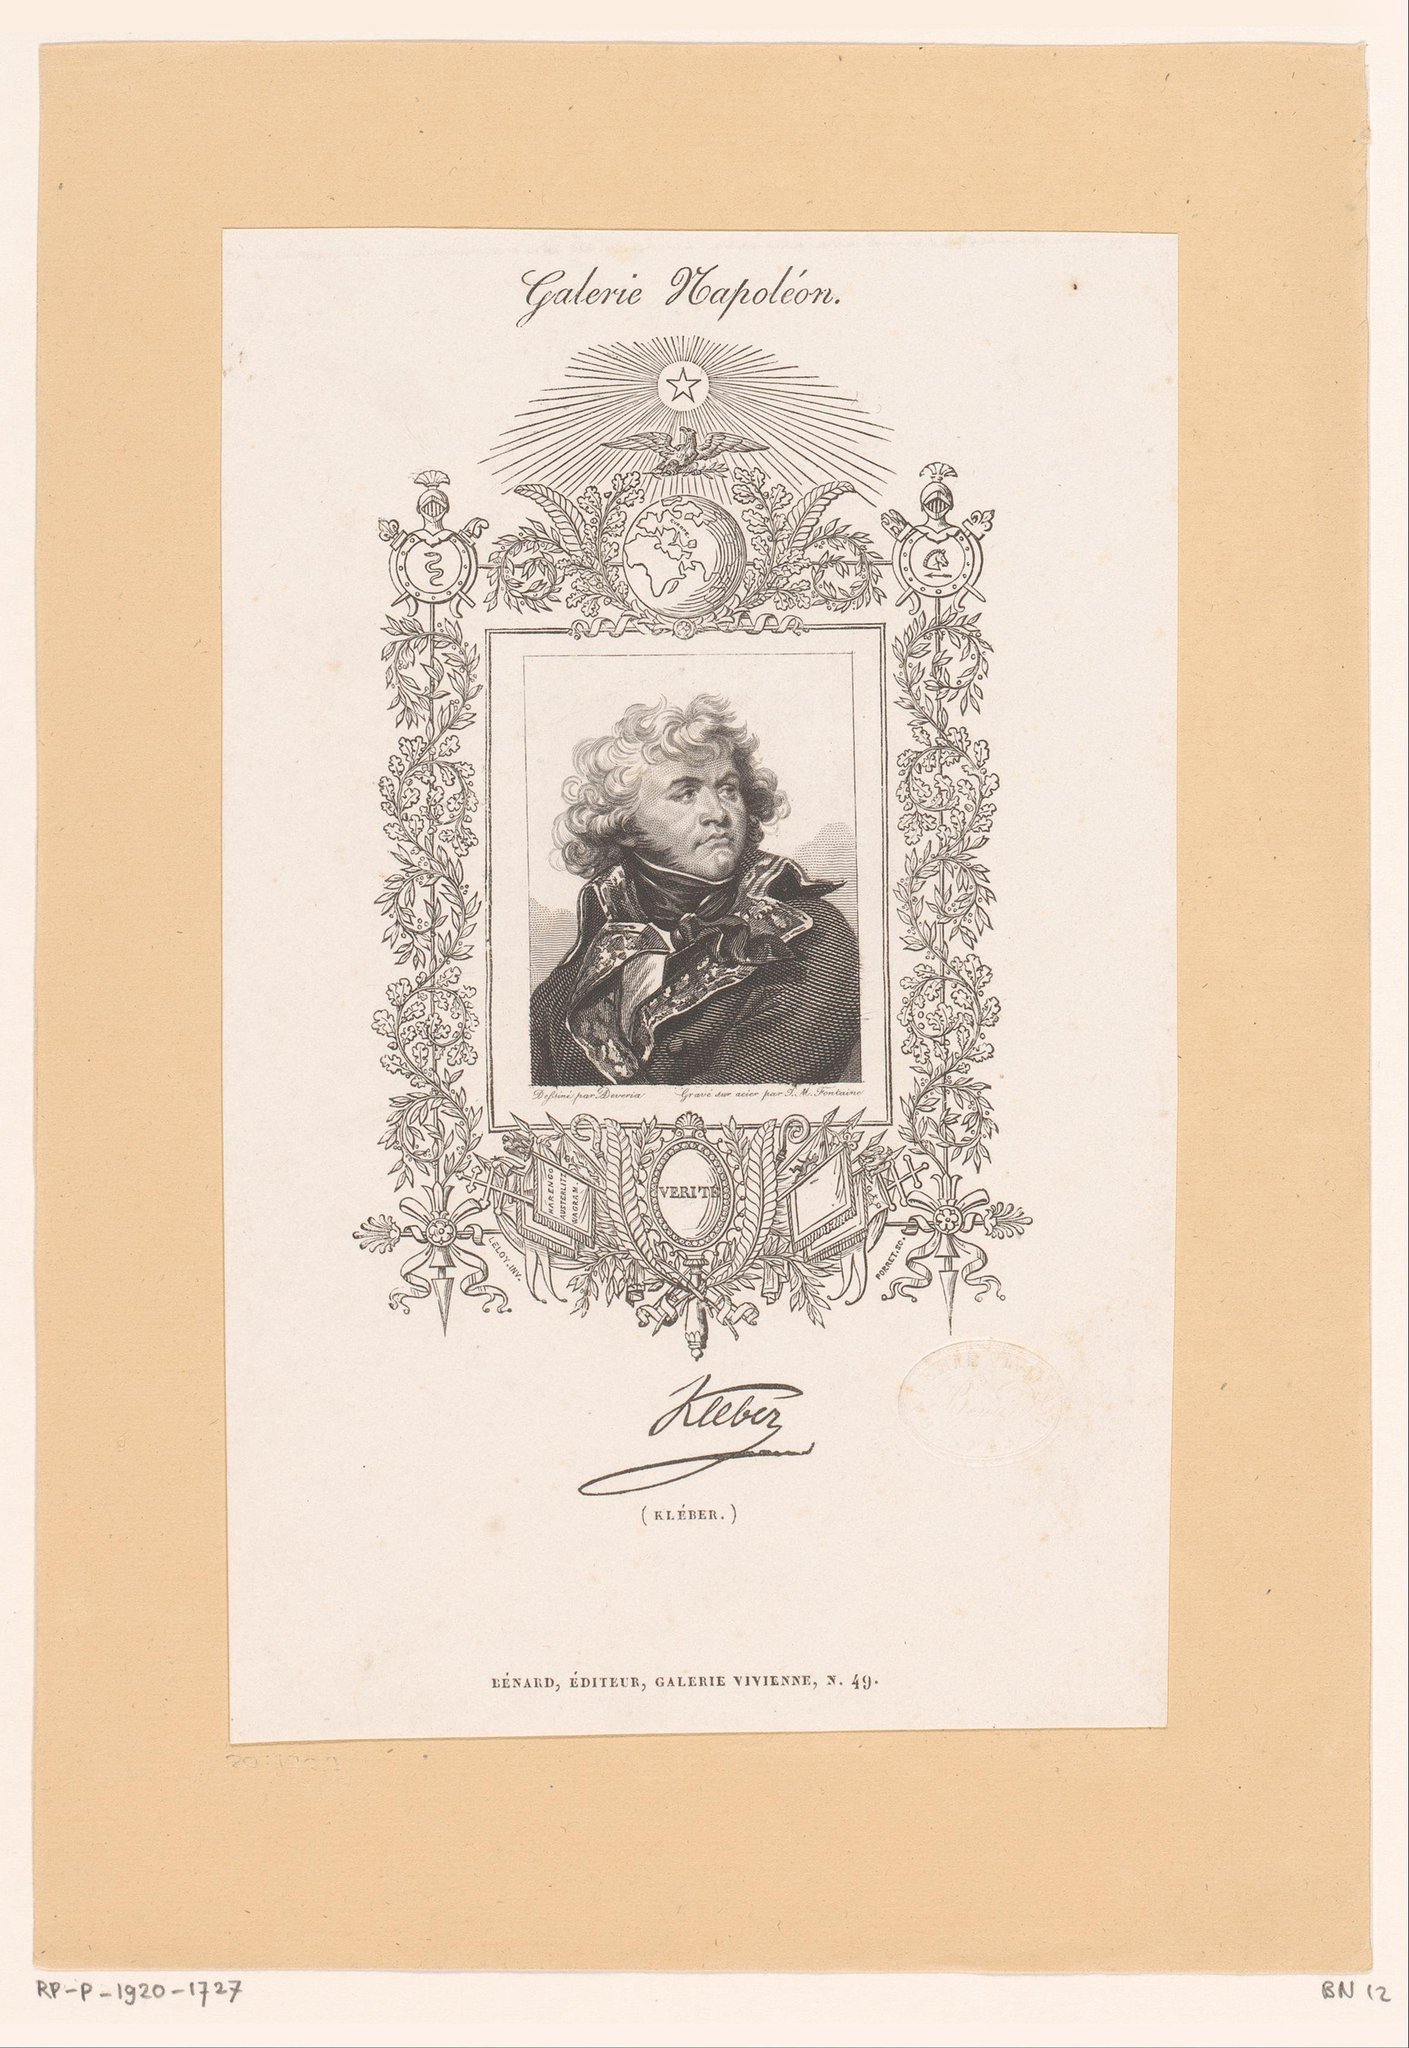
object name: print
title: Portret van Jean-Baptiste Kléber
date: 1829-1830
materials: paper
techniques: engraving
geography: france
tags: commander-in-chief, general, marshal, historical persons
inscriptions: check stamp: ‘Galerie Vivienne / Bénard’, collector's mark: Lugt 2228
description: Dit portret maakte deel uit van de serie "Galerie Napoléon", een collectie van honderd portretten van vooraanstaande figuren uit de omgeving van Napoleon Bonaparte. De serie werd uitgegeven door Bénard in Parijs in 1829-30.